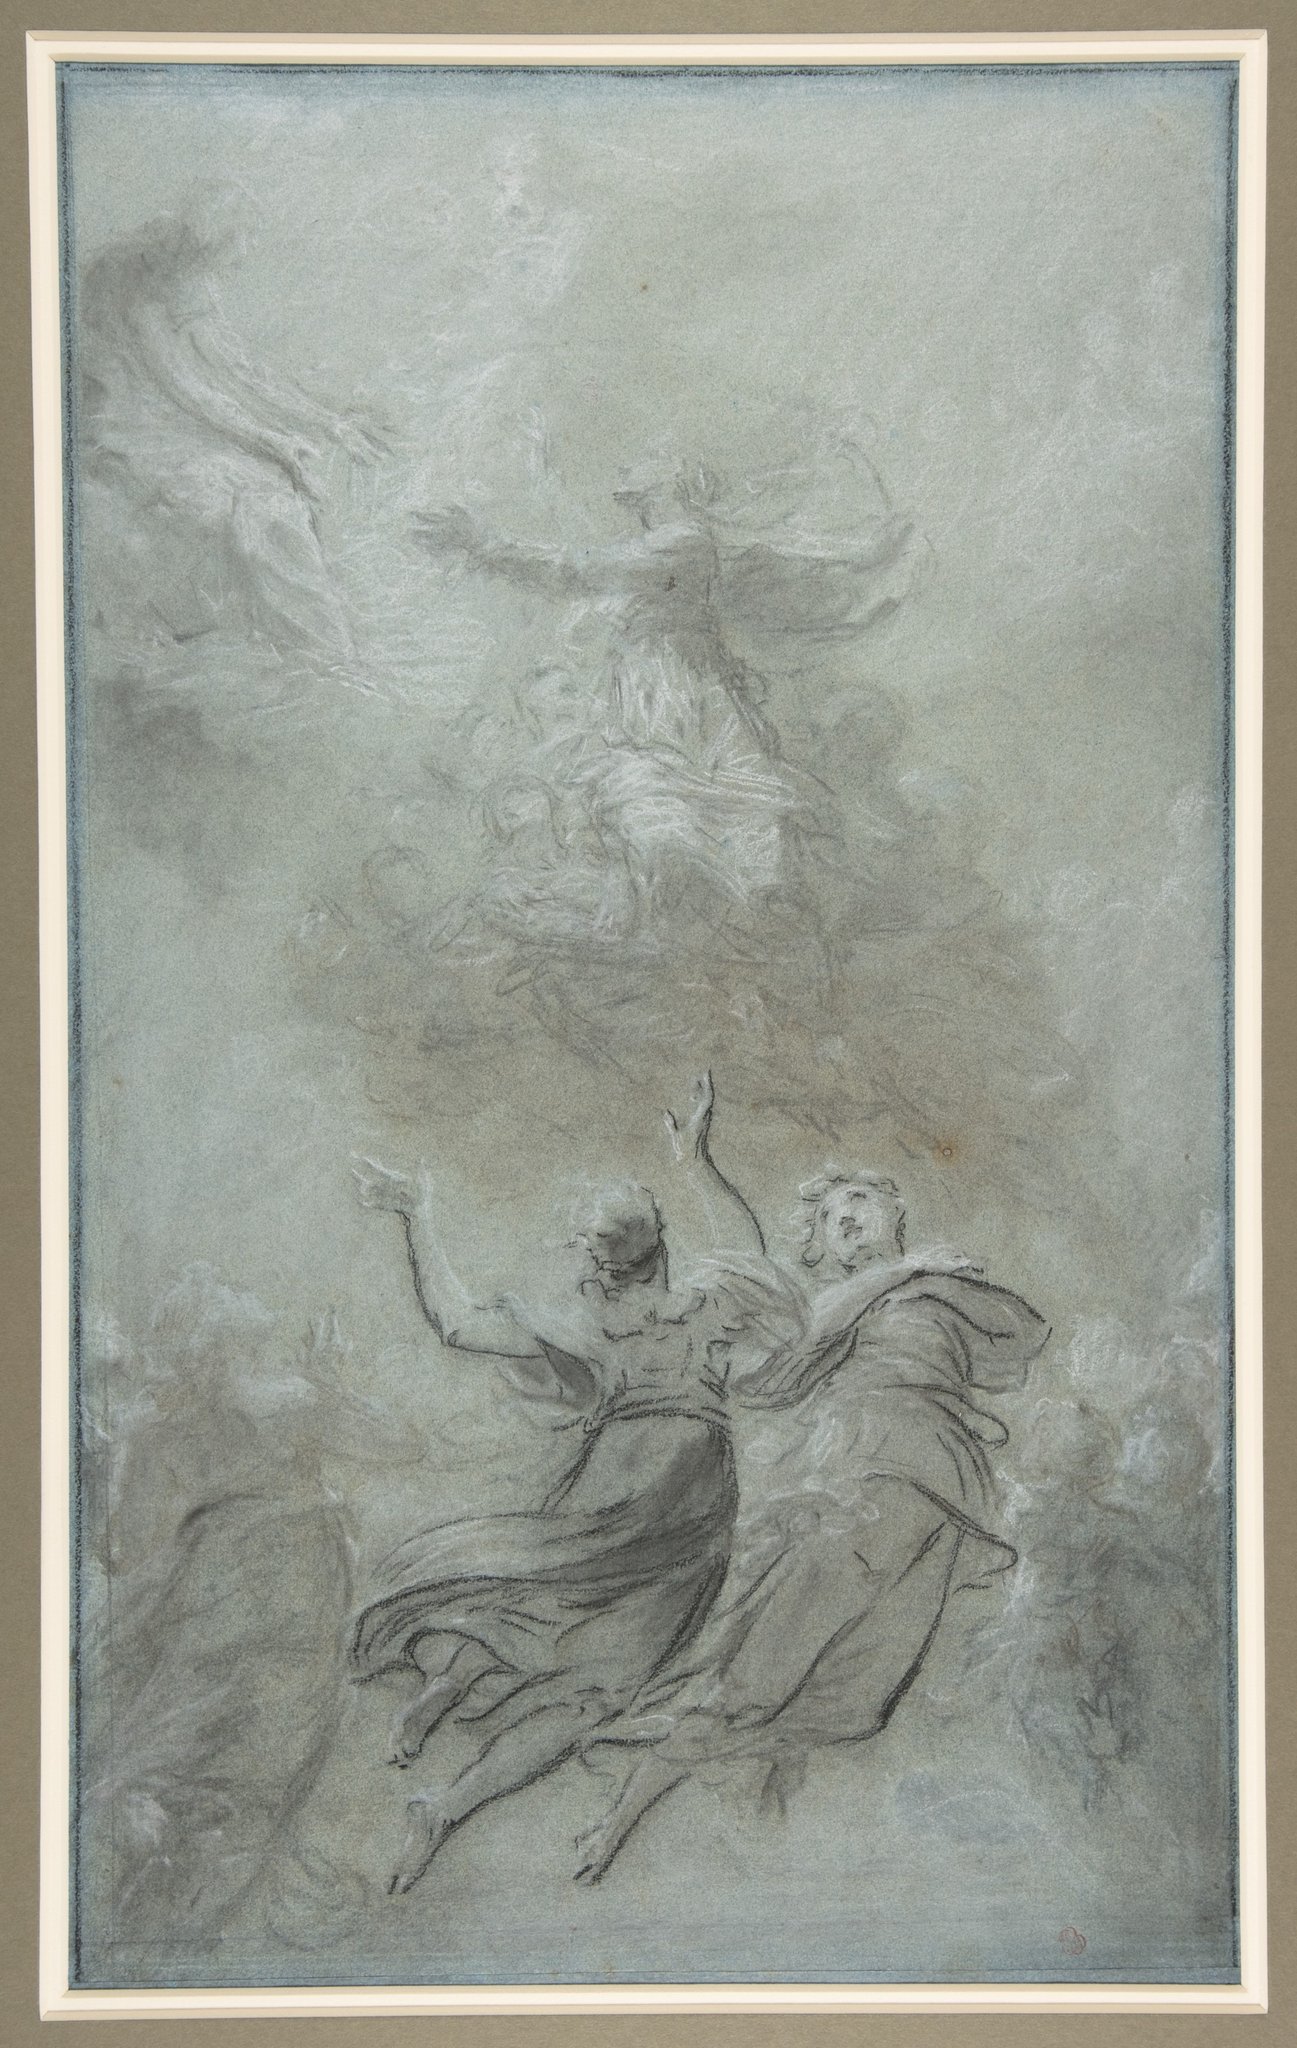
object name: drawing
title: The Assumption of the Virgin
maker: pierre paul prud'hon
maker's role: artist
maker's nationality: french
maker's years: 1758-1823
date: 1816-1819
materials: chalk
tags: assumption of the virgin